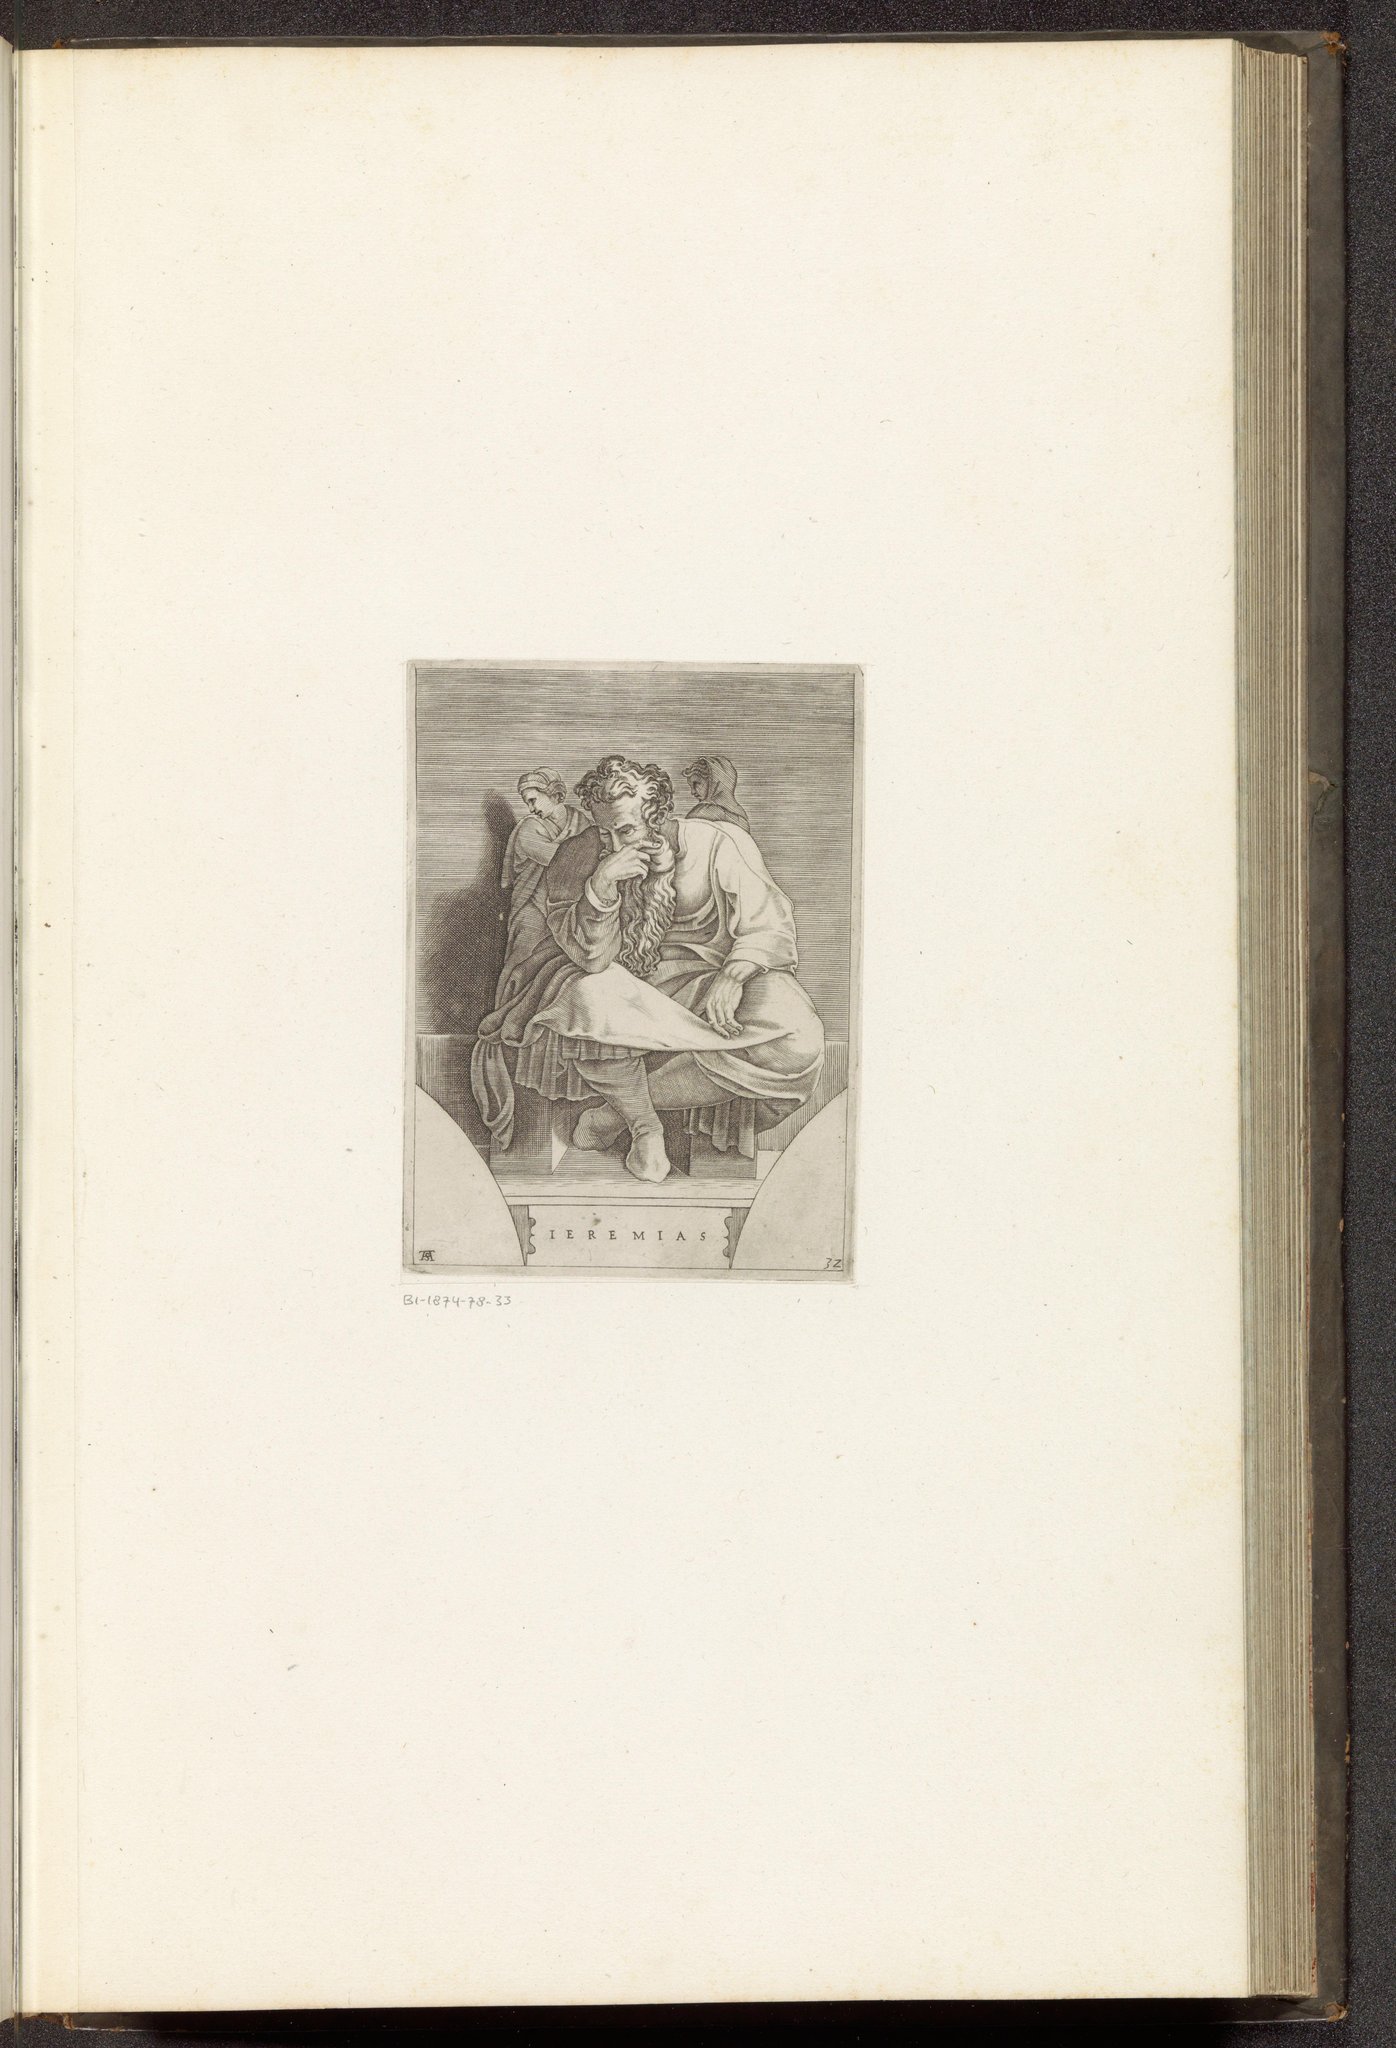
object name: print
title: Ieremias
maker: adamo scultori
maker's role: painter, print maker, sculptor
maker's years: 1530-1585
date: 1585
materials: paper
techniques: engraving, intaglio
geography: vatican city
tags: jeremiah (not in biblical context); possible attributes: book or scroll, 'the seething pot'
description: De profeet Jeremia zittend. Links en rechts van de profeet staan kleine figuren. Eén van de profeten van Michelangelo's plafondschildering. Titel in ondermarge en genummerd rechtsonder: 32. De prent maakt deel uit van een album.